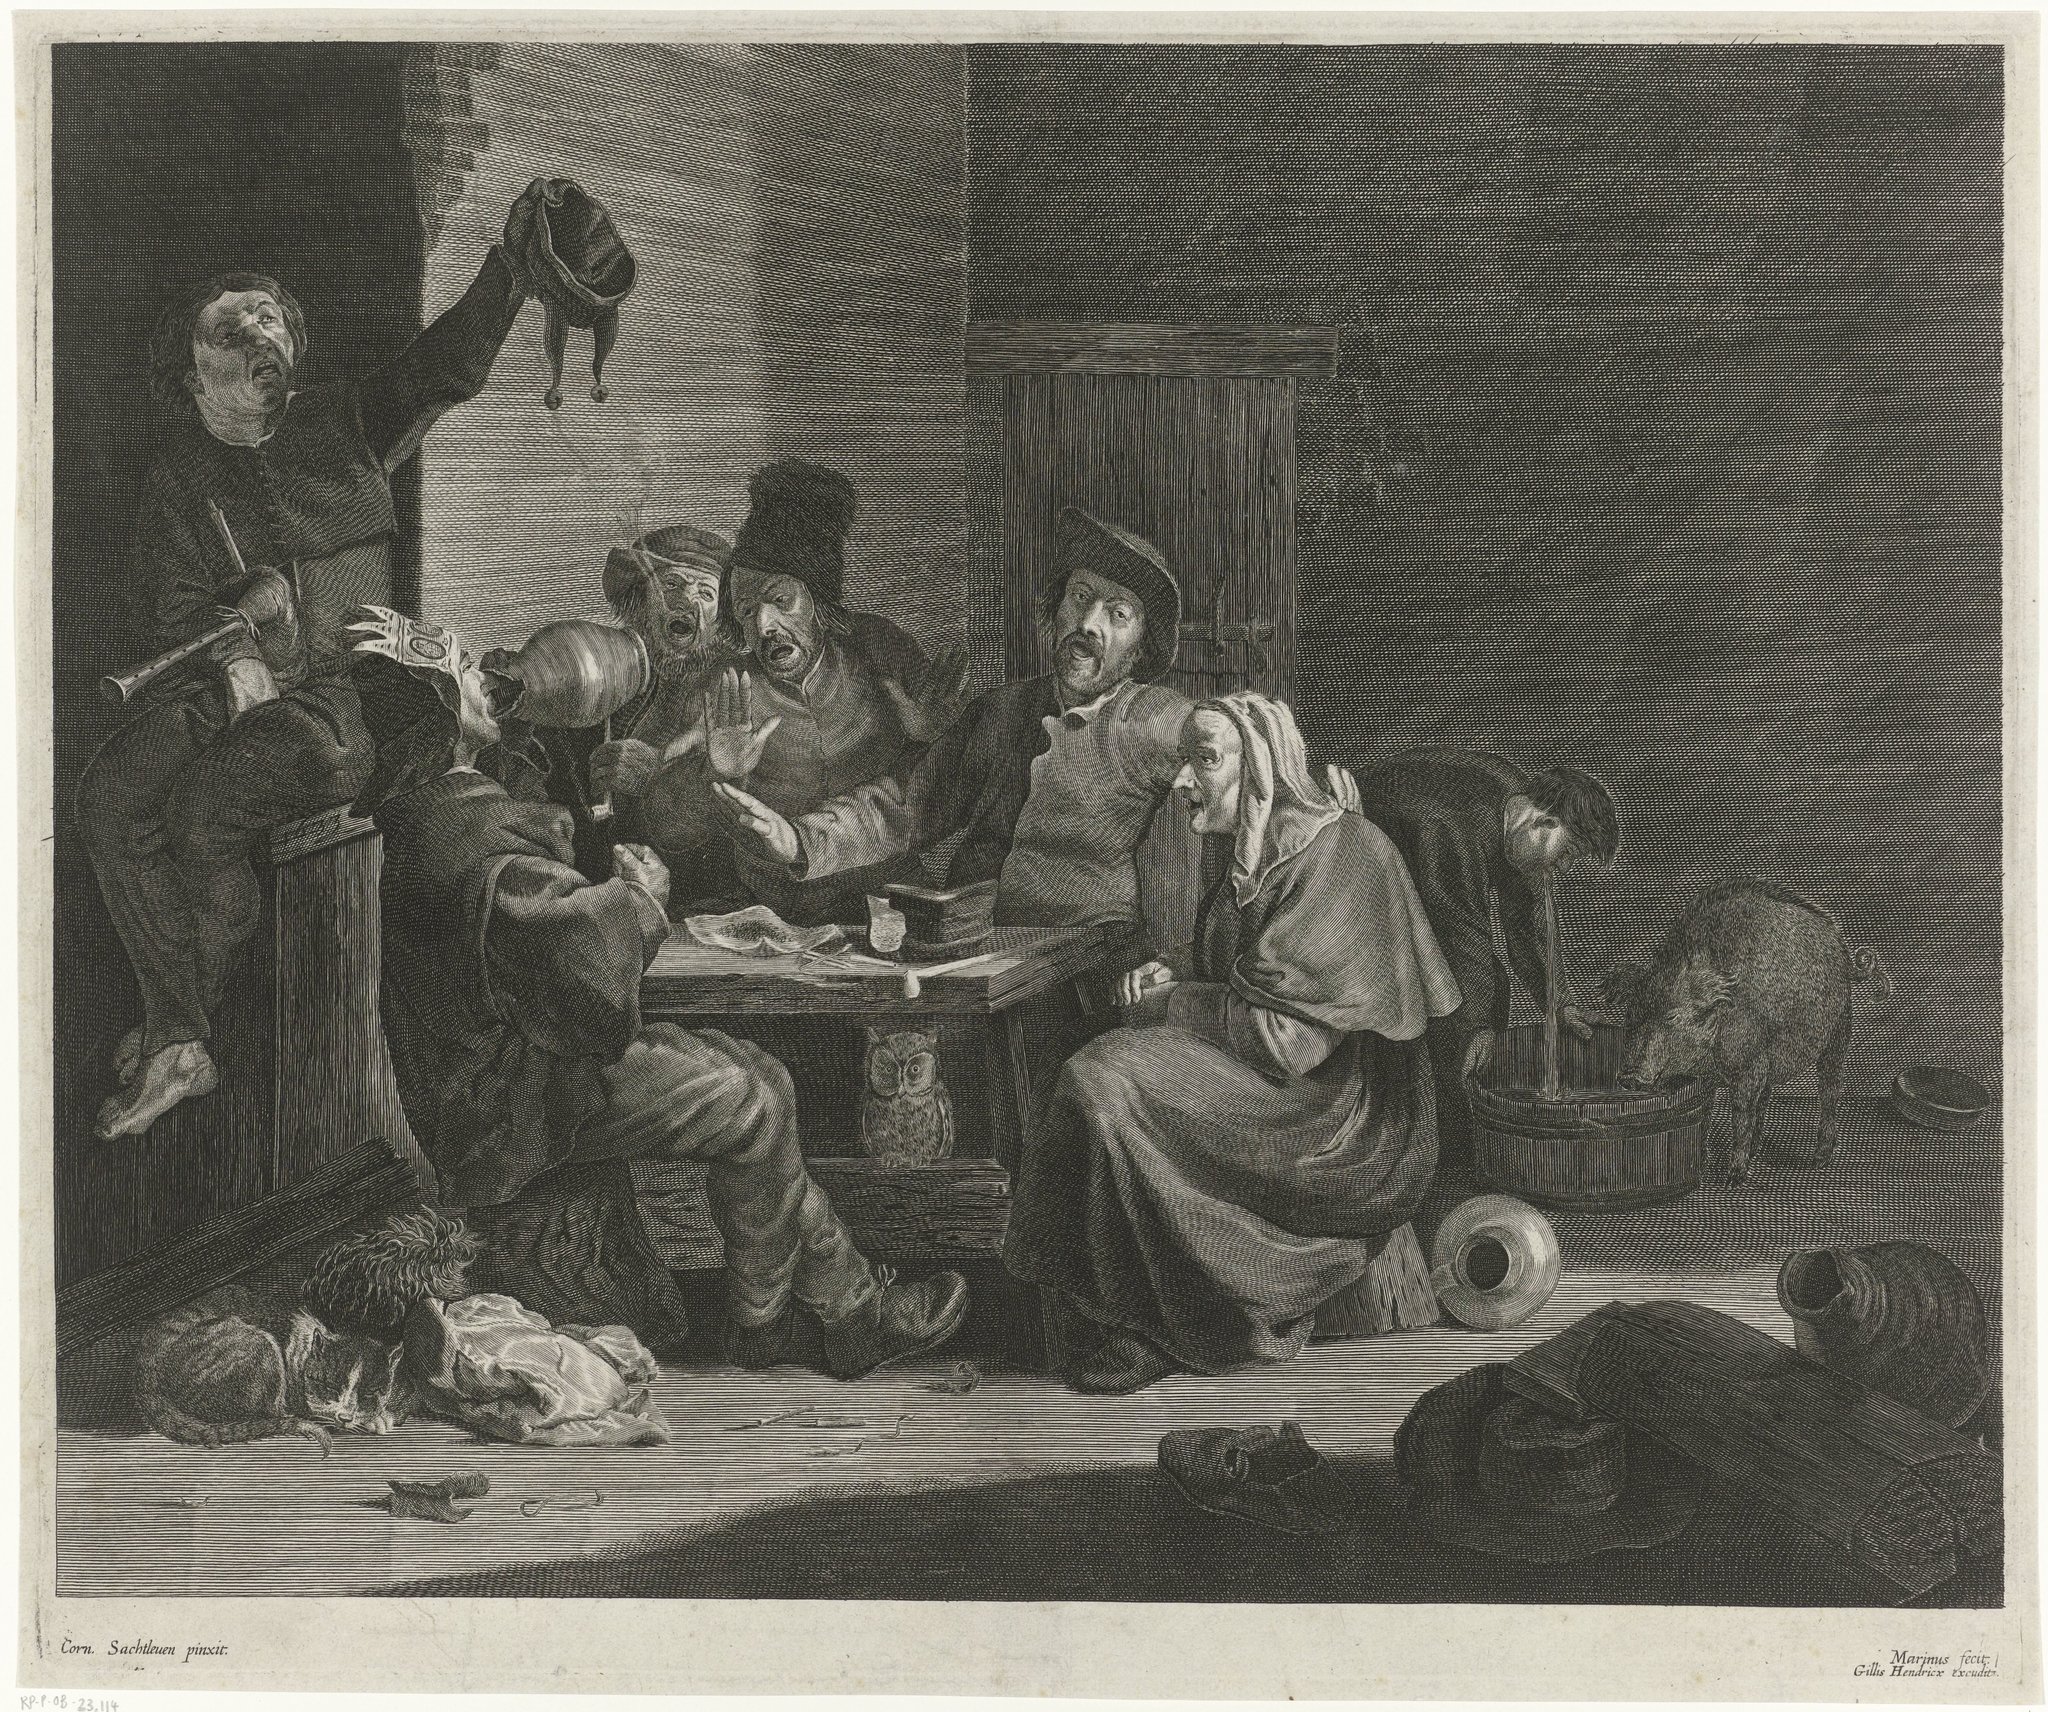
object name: print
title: Driekoningen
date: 1609-1639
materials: paper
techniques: engraving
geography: antwerp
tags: jar, jug (used as drinking-vessel), twelfth night, usually falling on the eve of january 6, drunkenness, drinking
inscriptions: collector's mark: Lugt 240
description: Een drinkend gezelschap in een interieur, waarvan een man met een kruik aan zijn mond een uitgeknipte kroon op zijn hoofd heeft, vanwege het driekoningenfeest. Rechts kotst een man in een voederbak van een varken. Links een doedelzakspeler met een narrenkap in zijn hand.